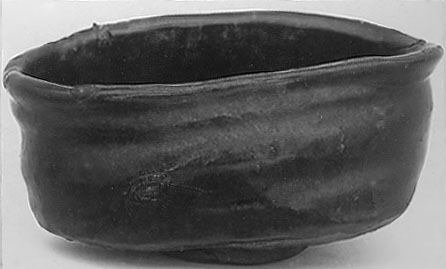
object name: teabowl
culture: japanese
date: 1701-1800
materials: clay, glaze